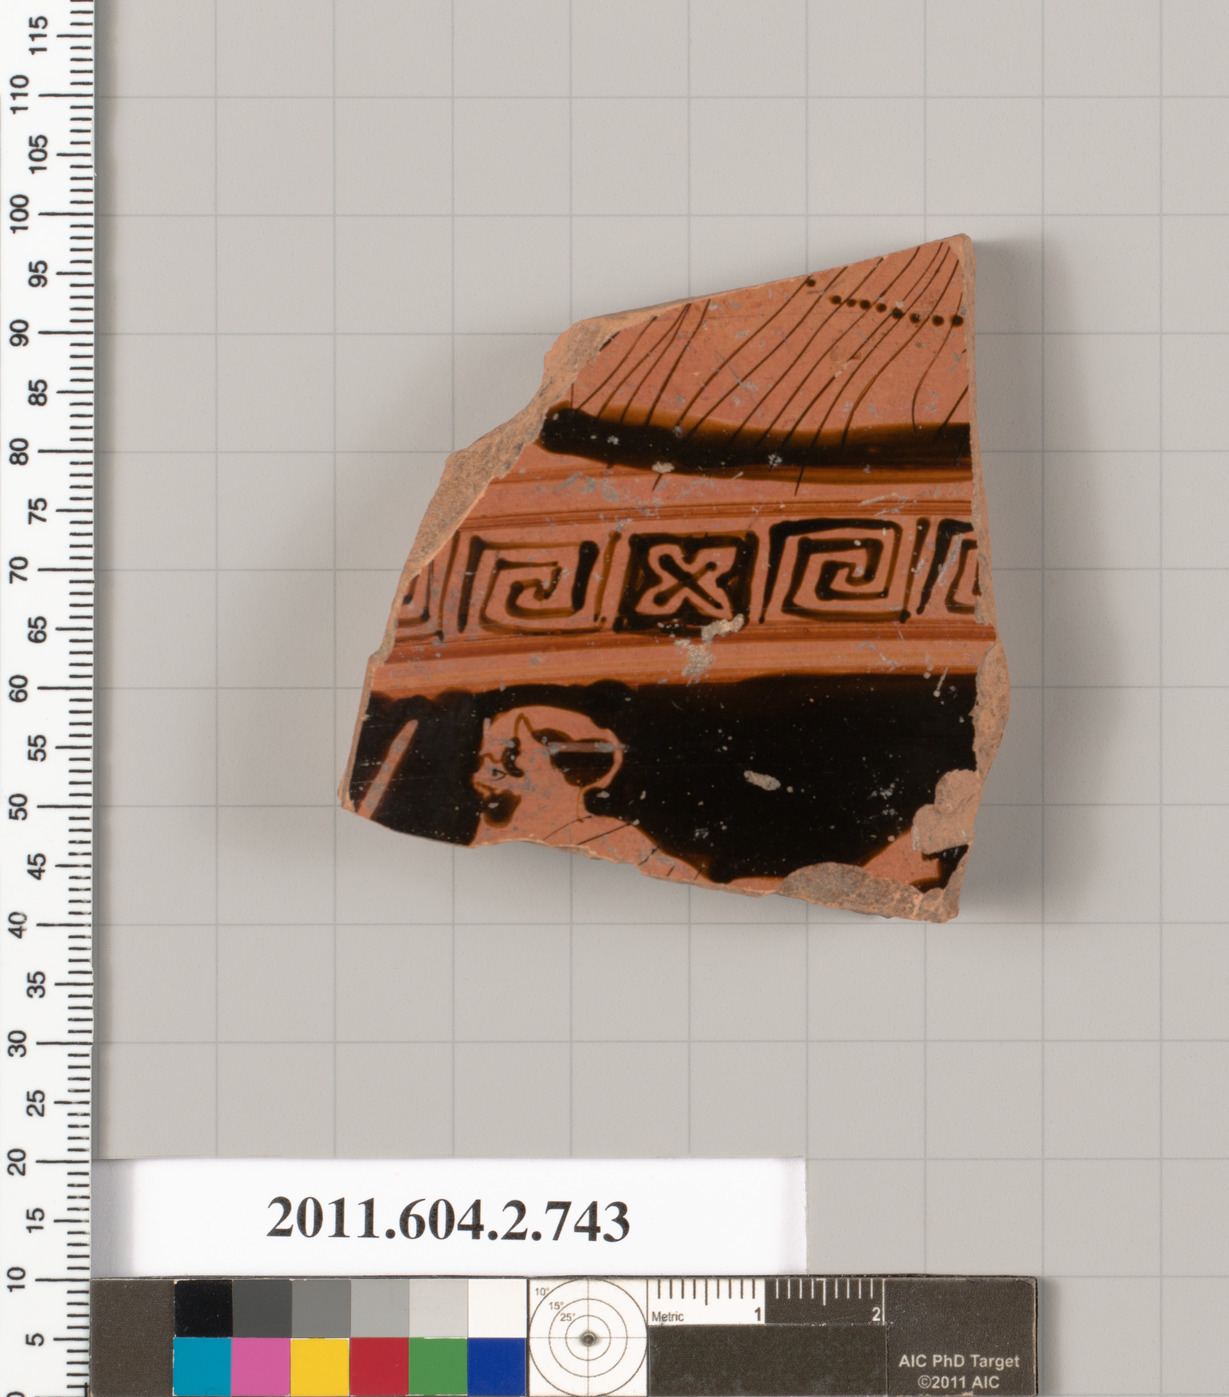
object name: calyx krater fragment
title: Terracotta fragment of a calyx-krater (bowl for mixing wine and water)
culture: greek, attic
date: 467-435 BCE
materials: terracotta